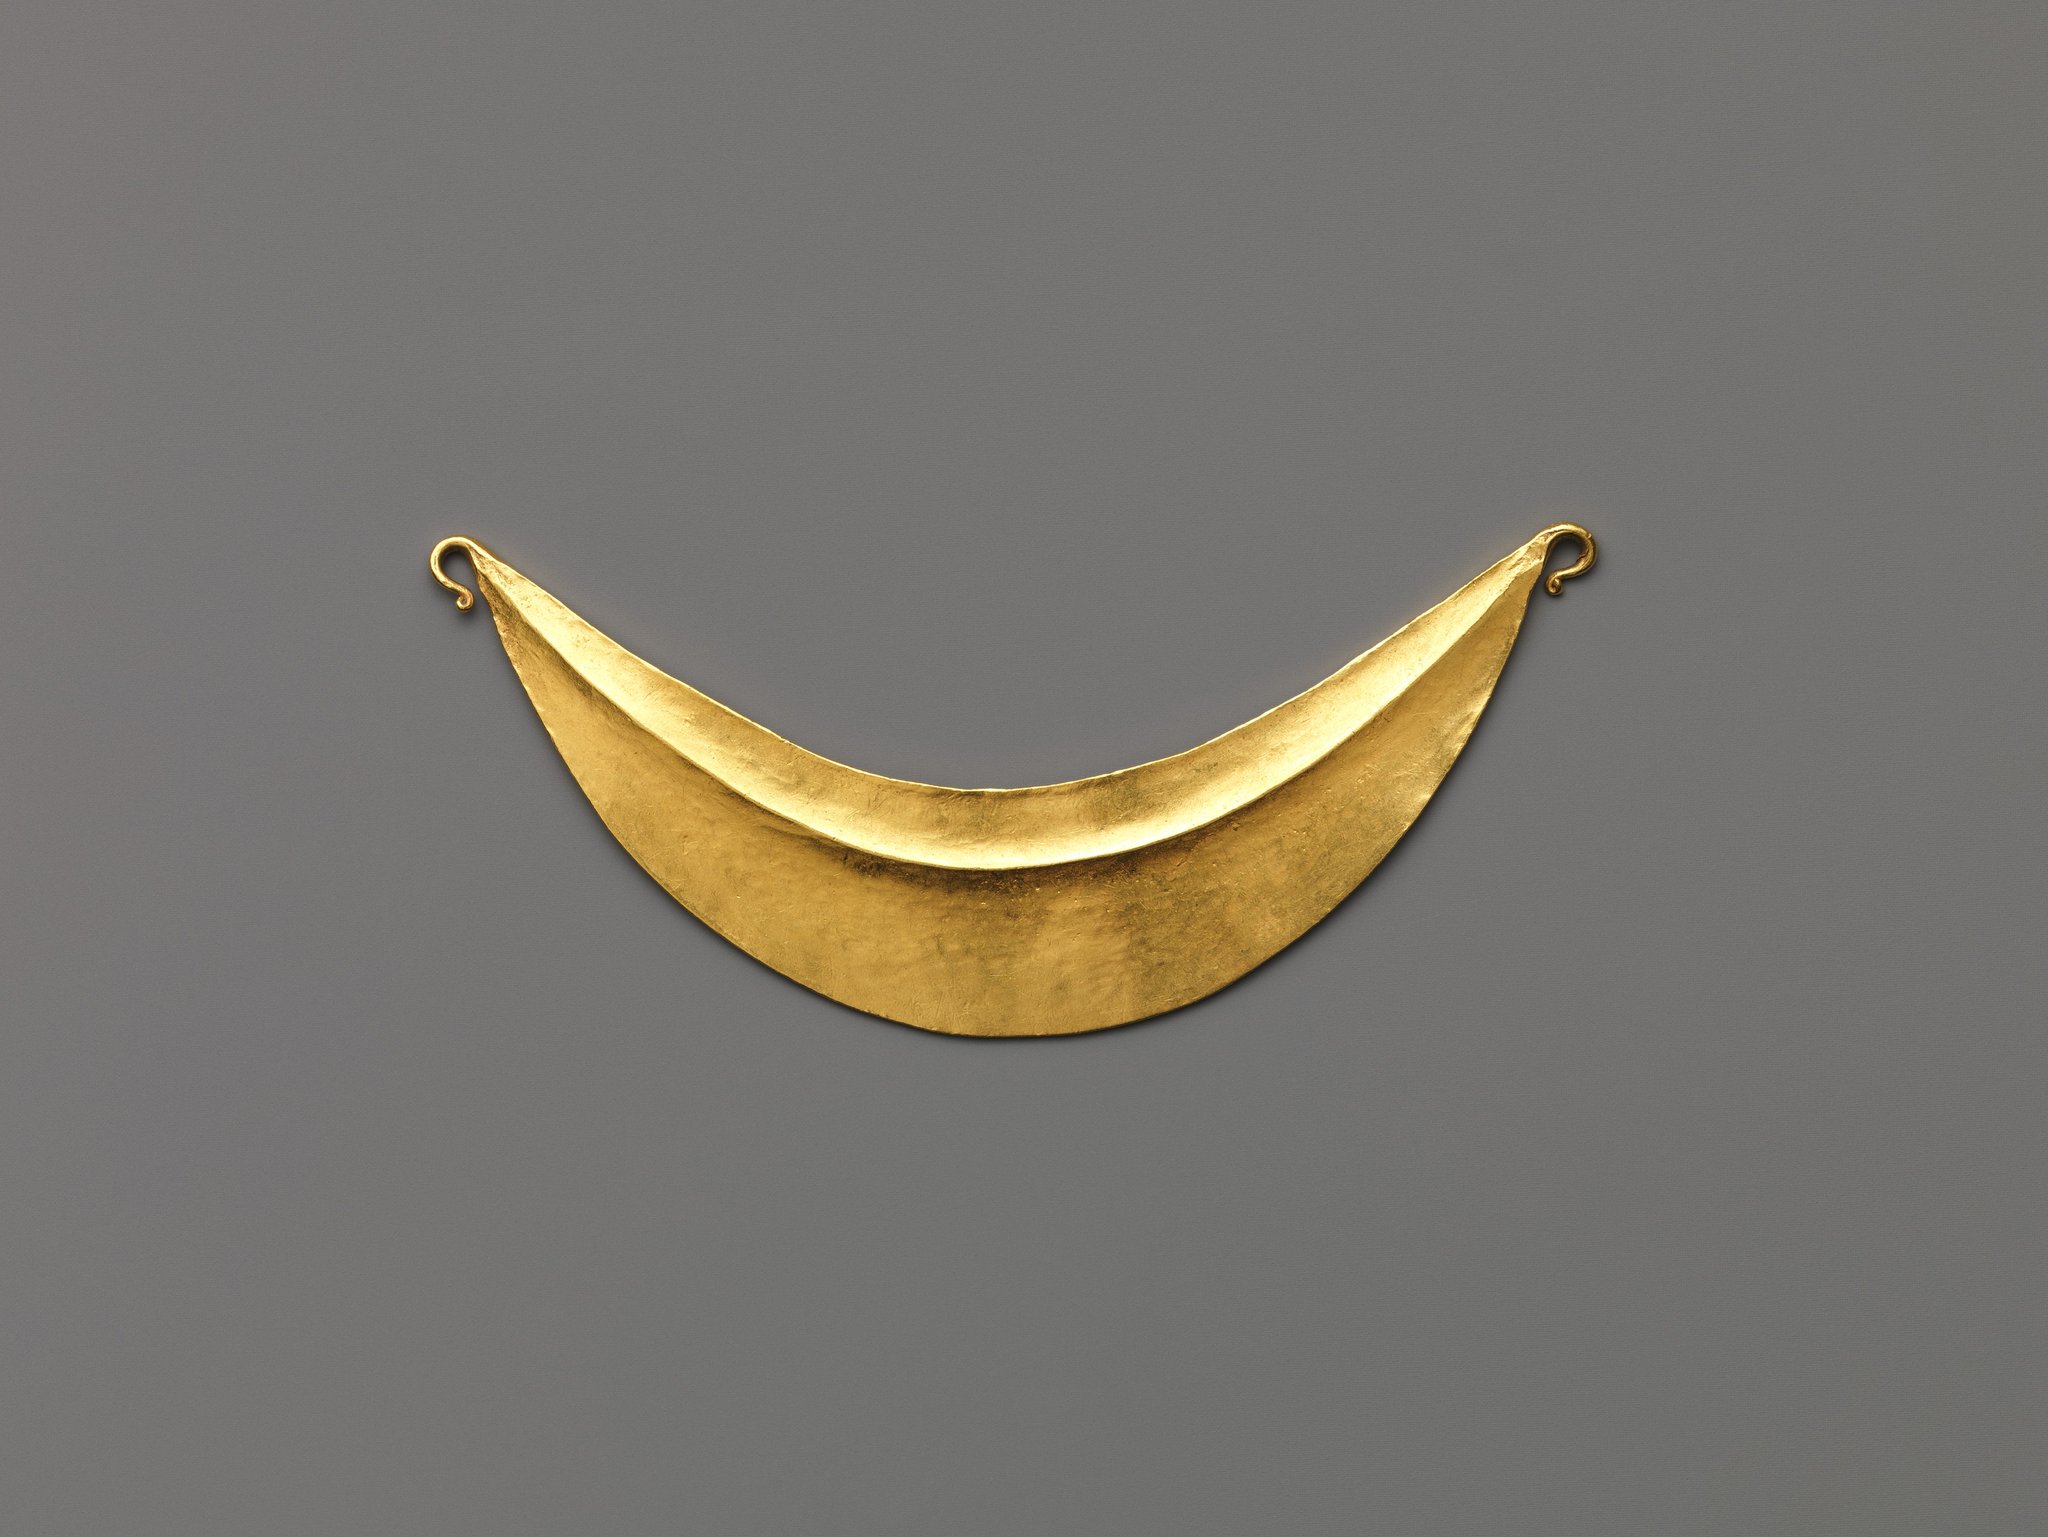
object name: pendant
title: Moon-Shaped Pendant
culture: indonesian, javanese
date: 701-833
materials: gold